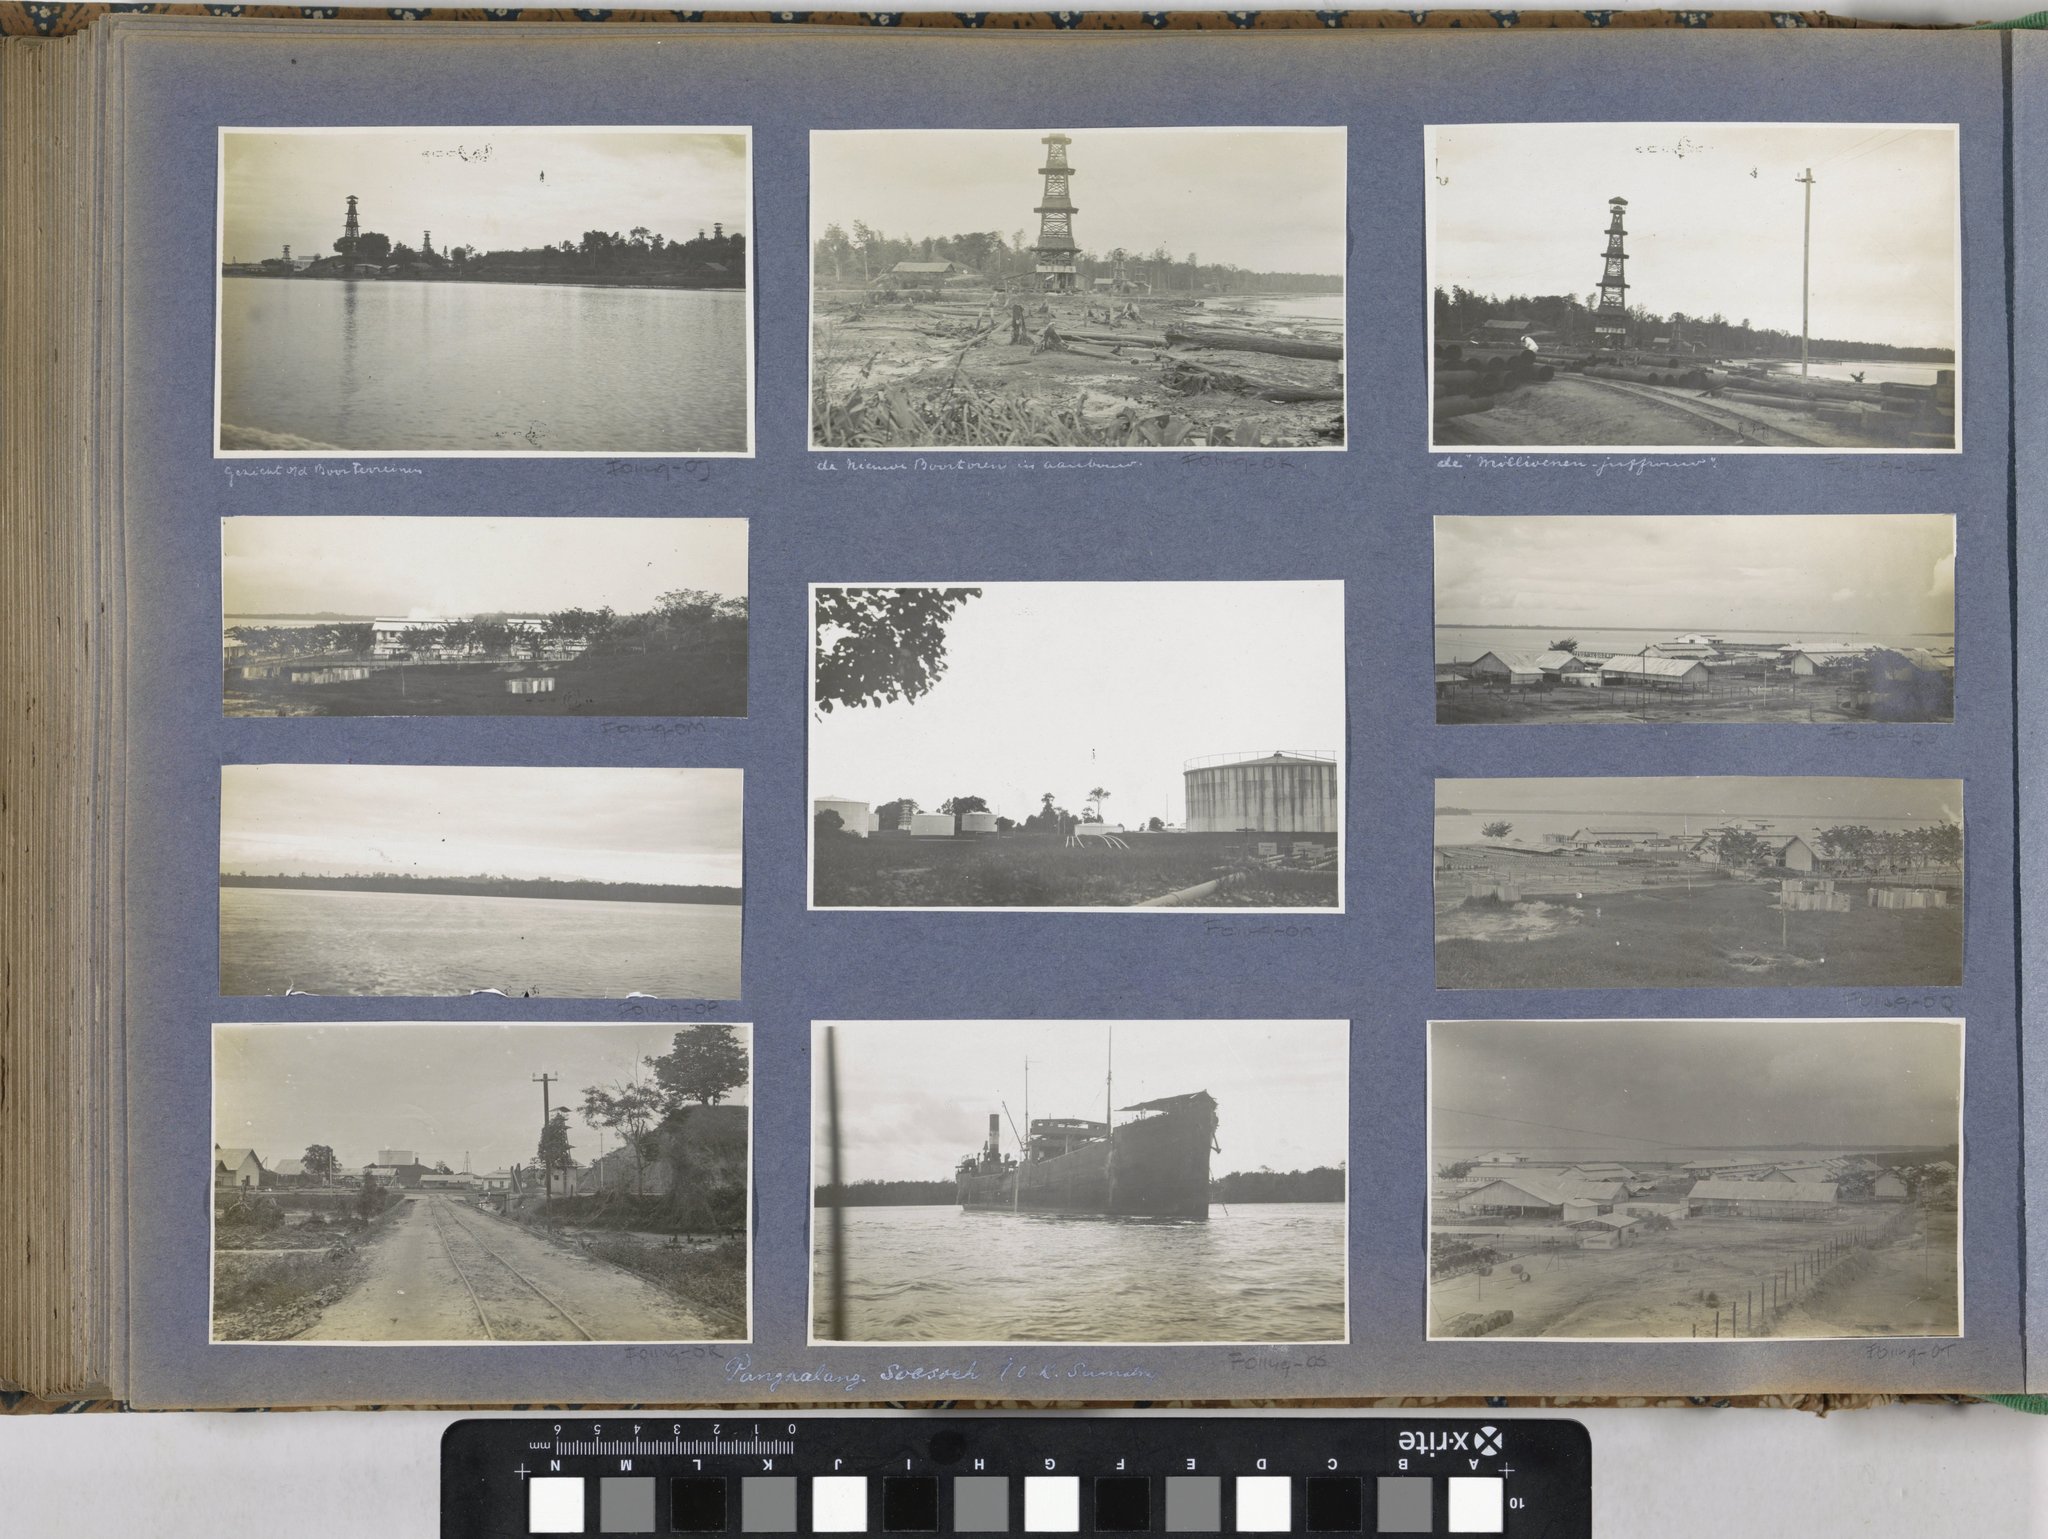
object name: photograph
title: Fabriekscomplex te Pangkalansusu op Sumatra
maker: Anonymous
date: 1900-1920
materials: paper, photographic support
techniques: gelatin silver print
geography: sumatra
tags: oil; oil refinery, sumatra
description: Onderdeel van reisalbum met foto's van bedrijvigheid en bezienswaardigheden op Sumatra en Java en van de reis naar en van Nederlands-Indië.